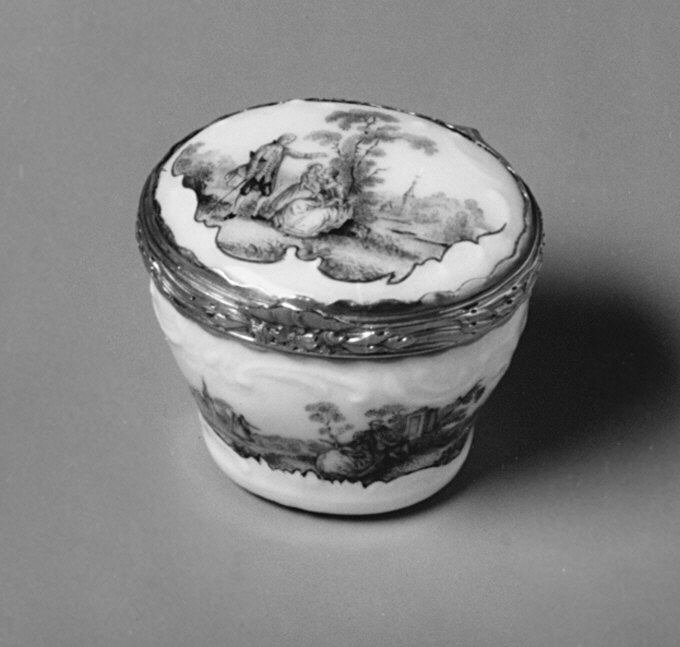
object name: thimble case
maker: meissen manufactory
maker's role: manufactory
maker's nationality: german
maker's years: 1710-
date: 1760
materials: gold, hard paste porcelain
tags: men